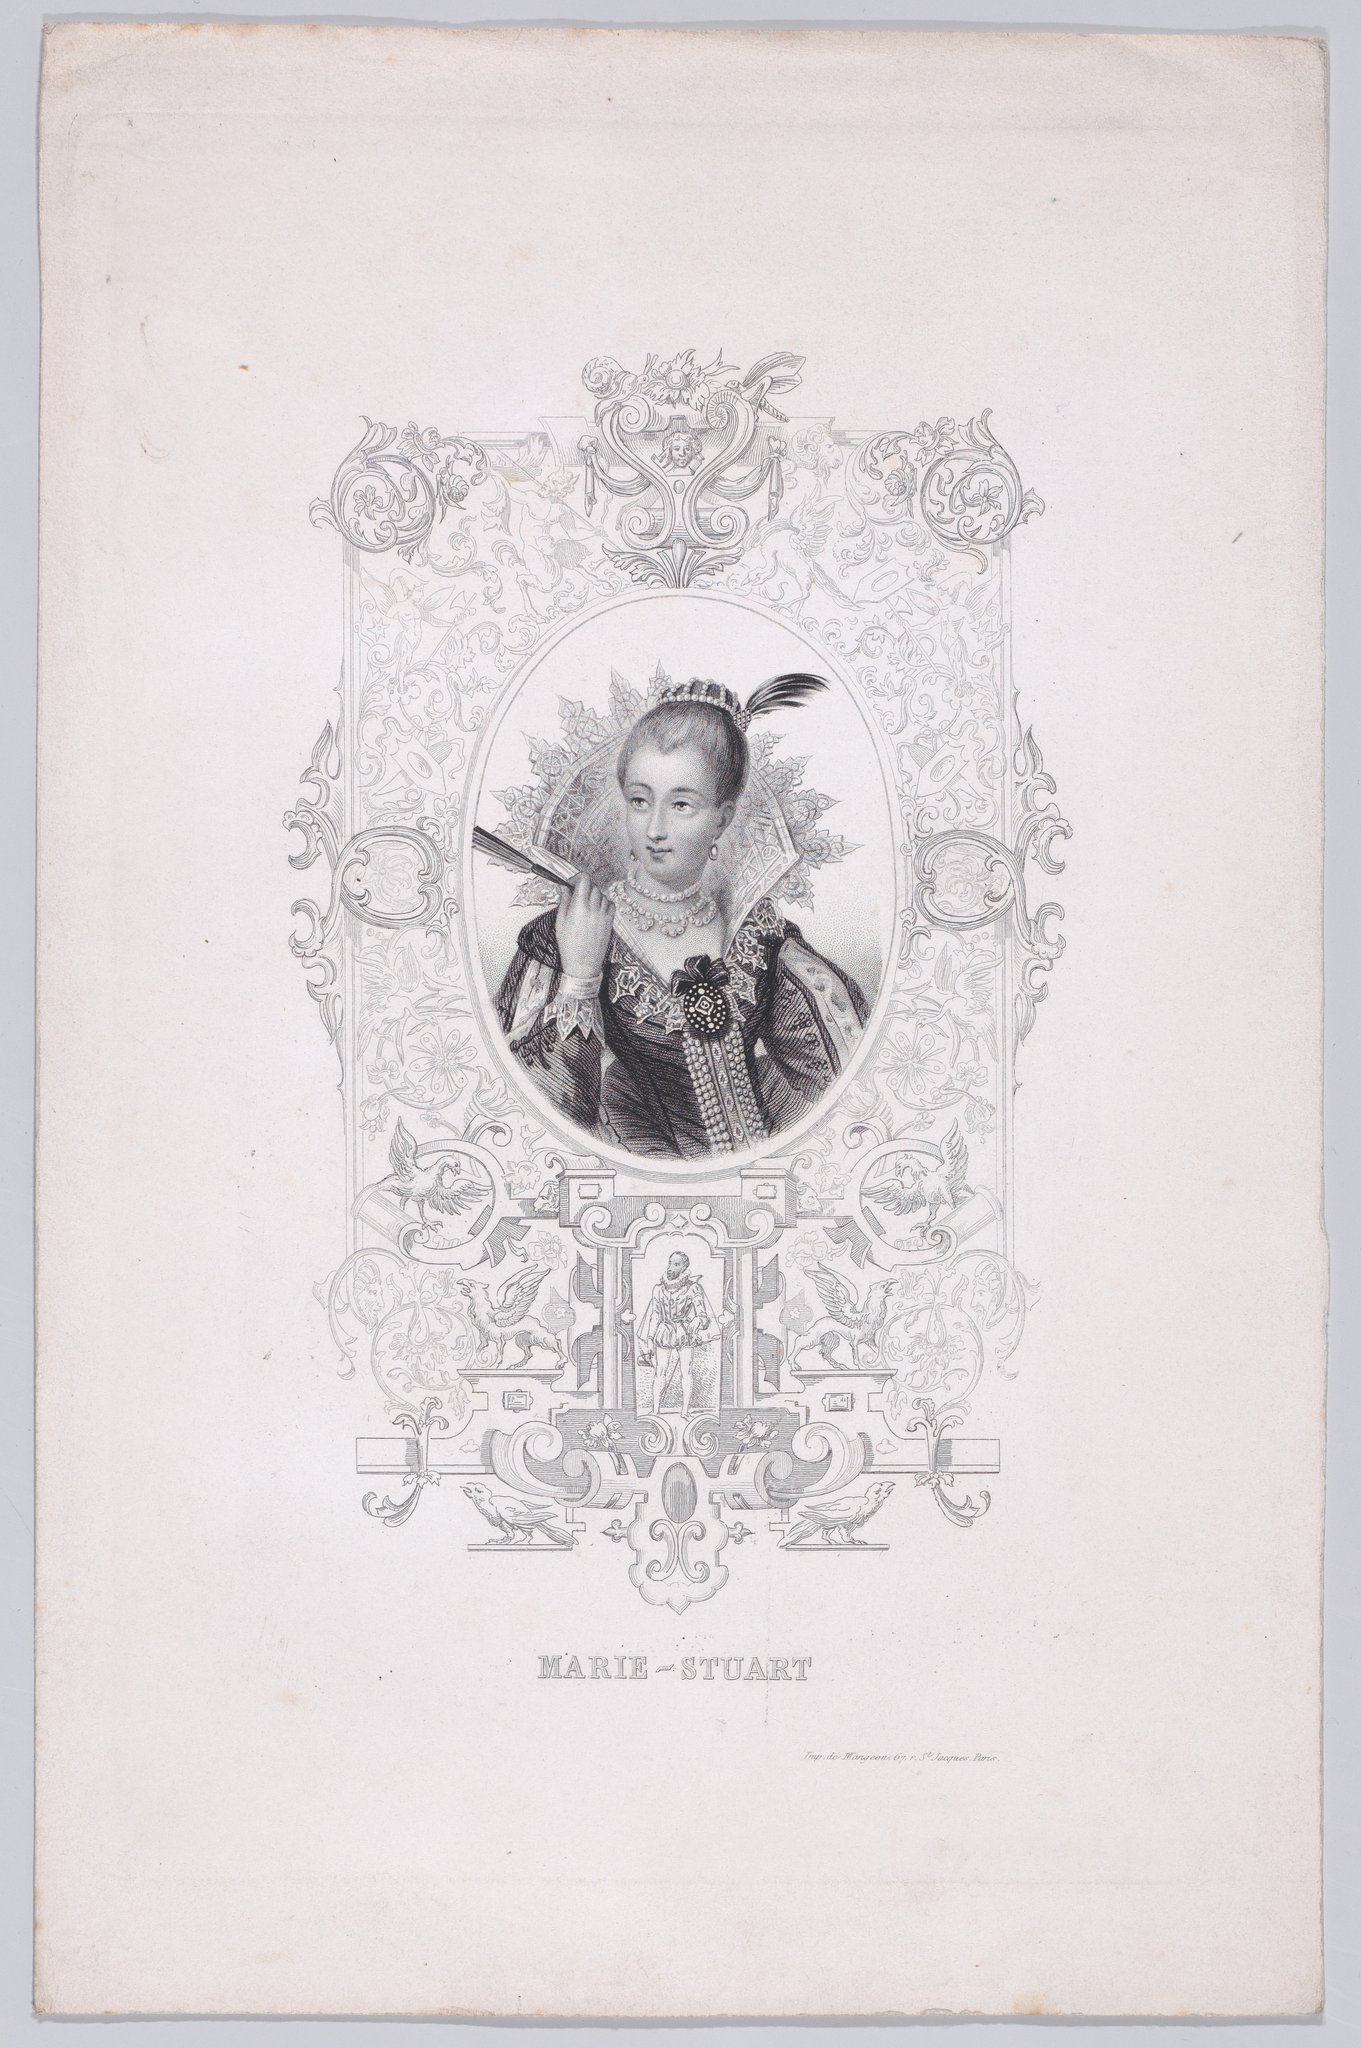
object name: print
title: Mary, Queen of Scots set in an ornamental frame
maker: mangeon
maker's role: publisher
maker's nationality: french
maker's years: 1835-1878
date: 1834-1866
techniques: etching, engraving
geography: france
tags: queens,women,mary queen of scots